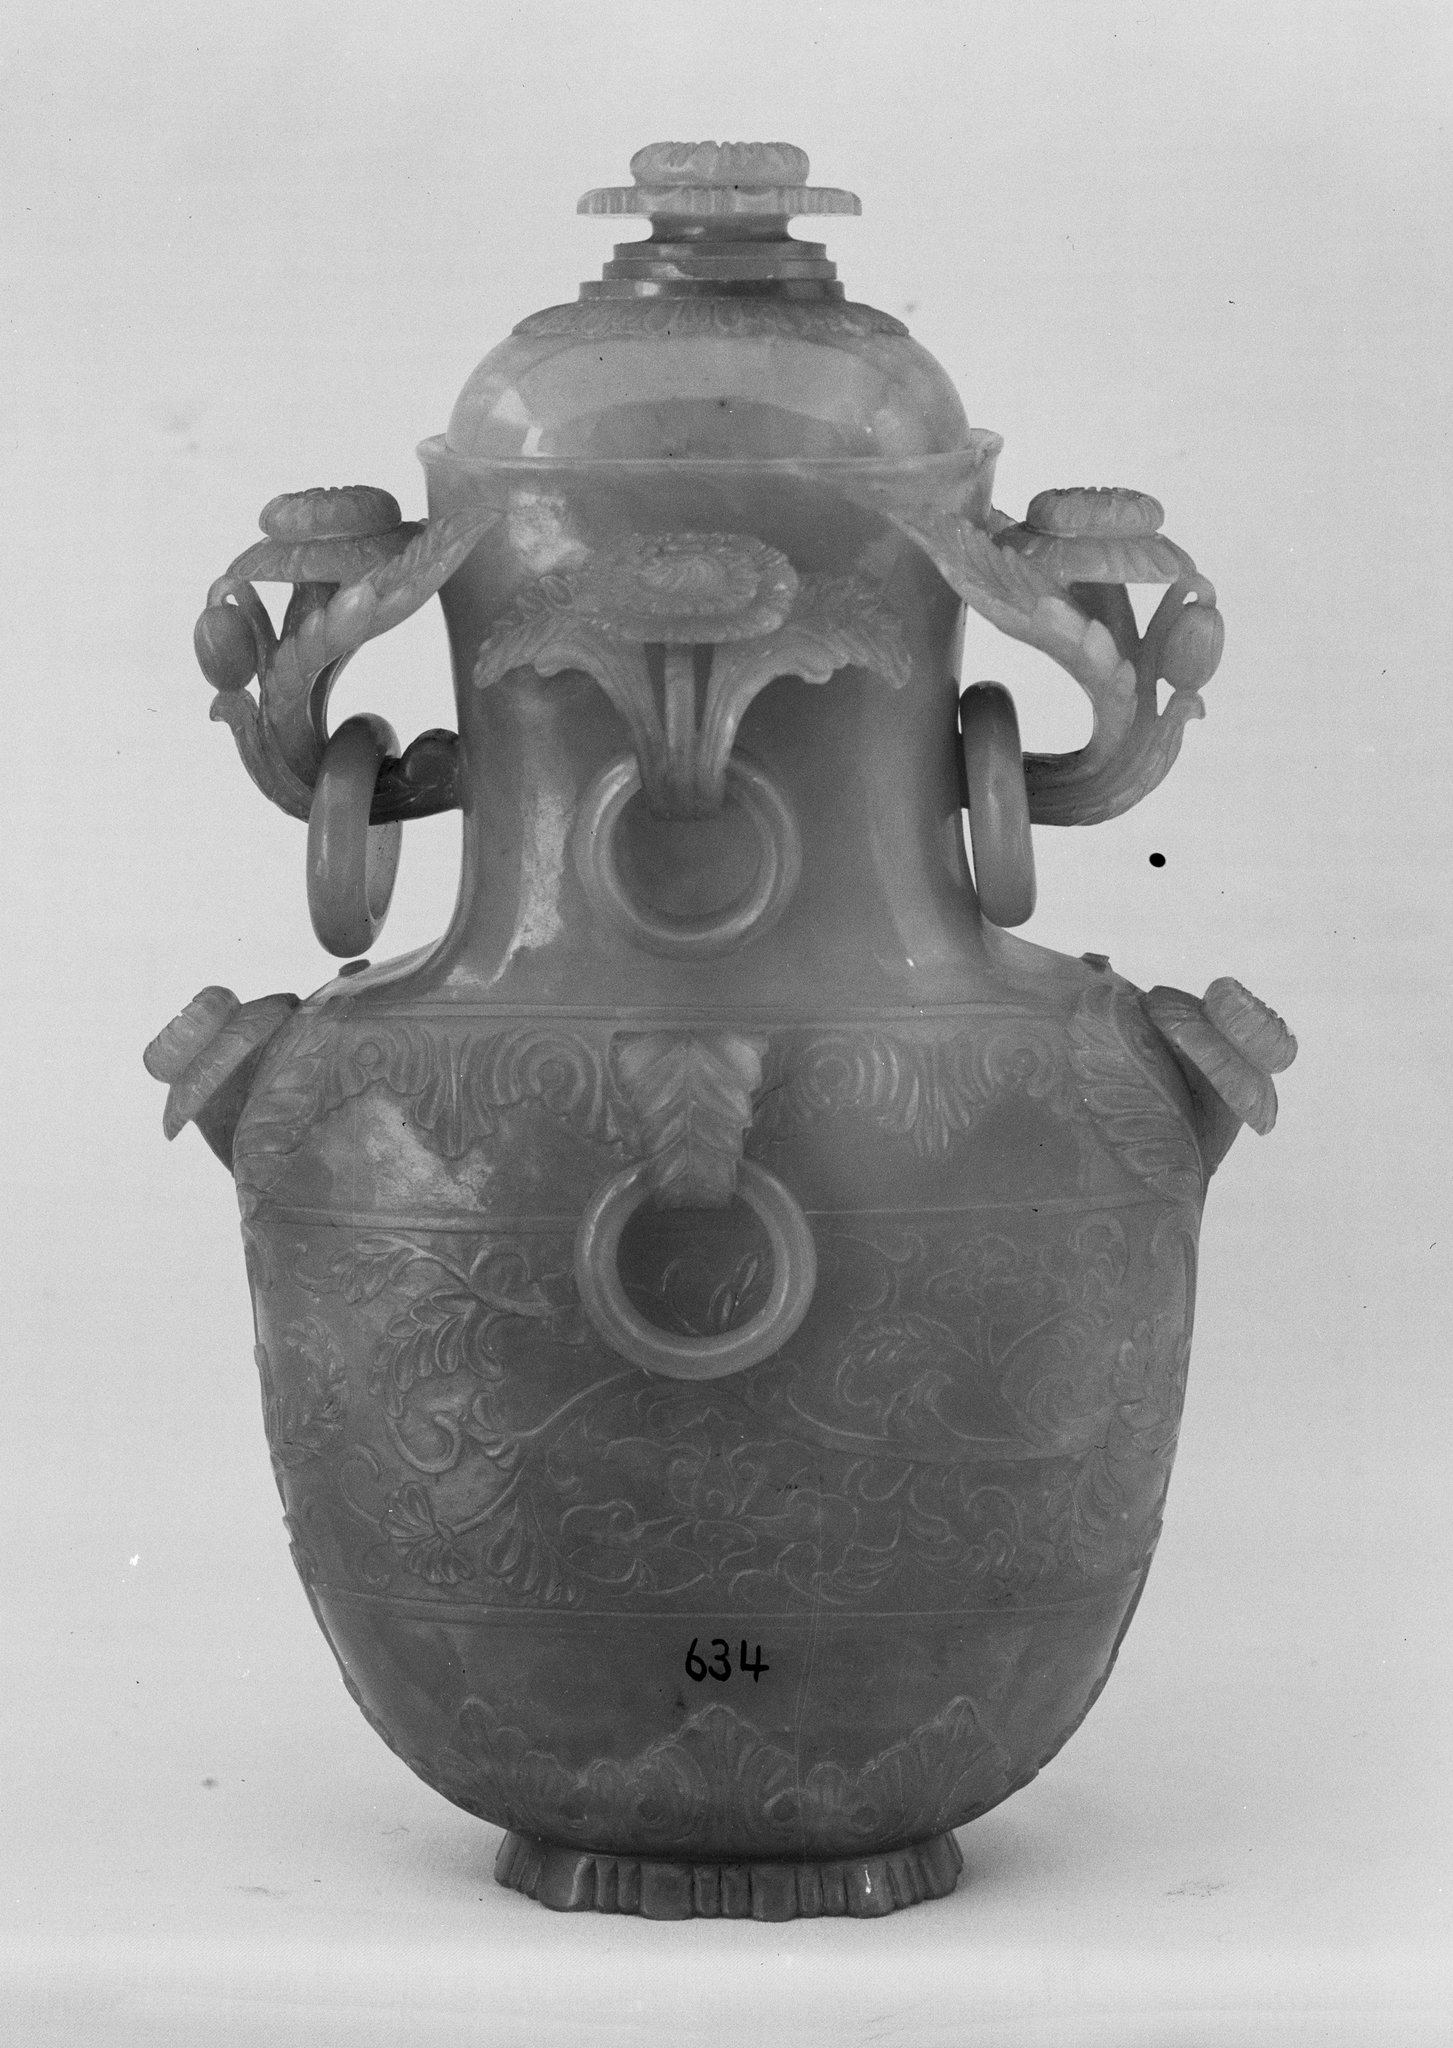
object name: vase with cover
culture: chinese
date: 1736-1795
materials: jade